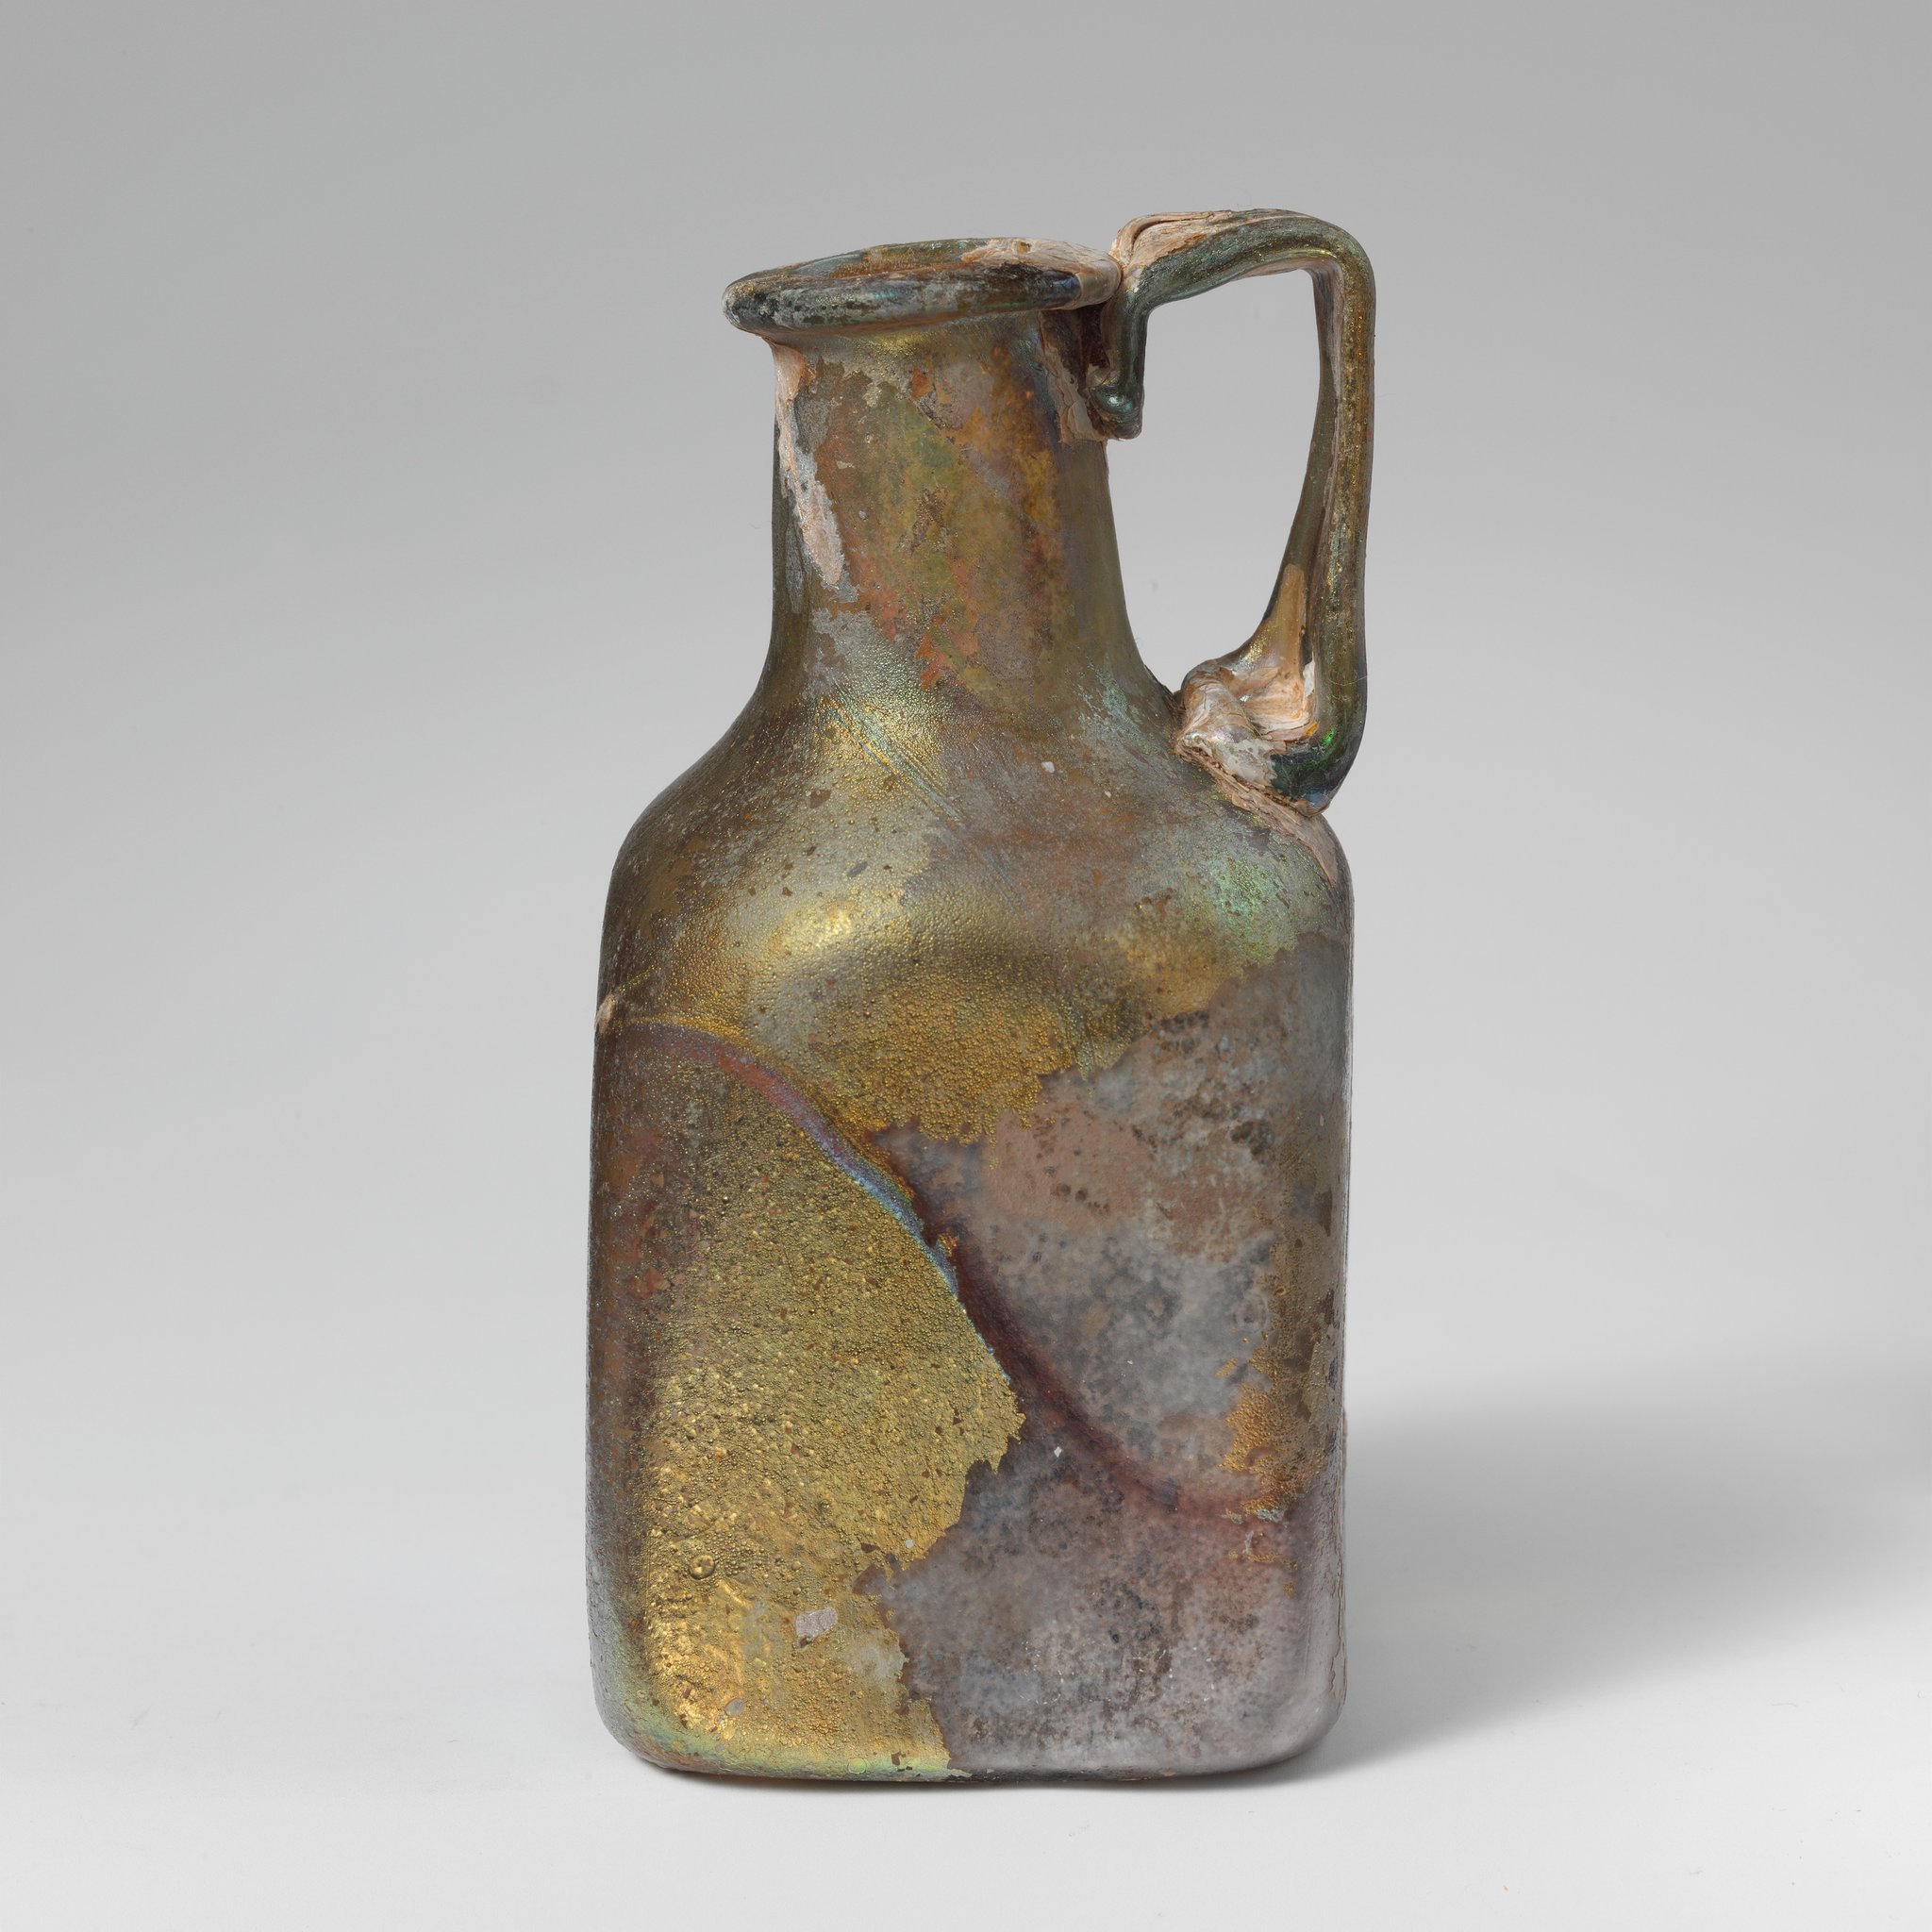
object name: bottle, square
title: Glass square bottle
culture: roman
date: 101-300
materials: glass